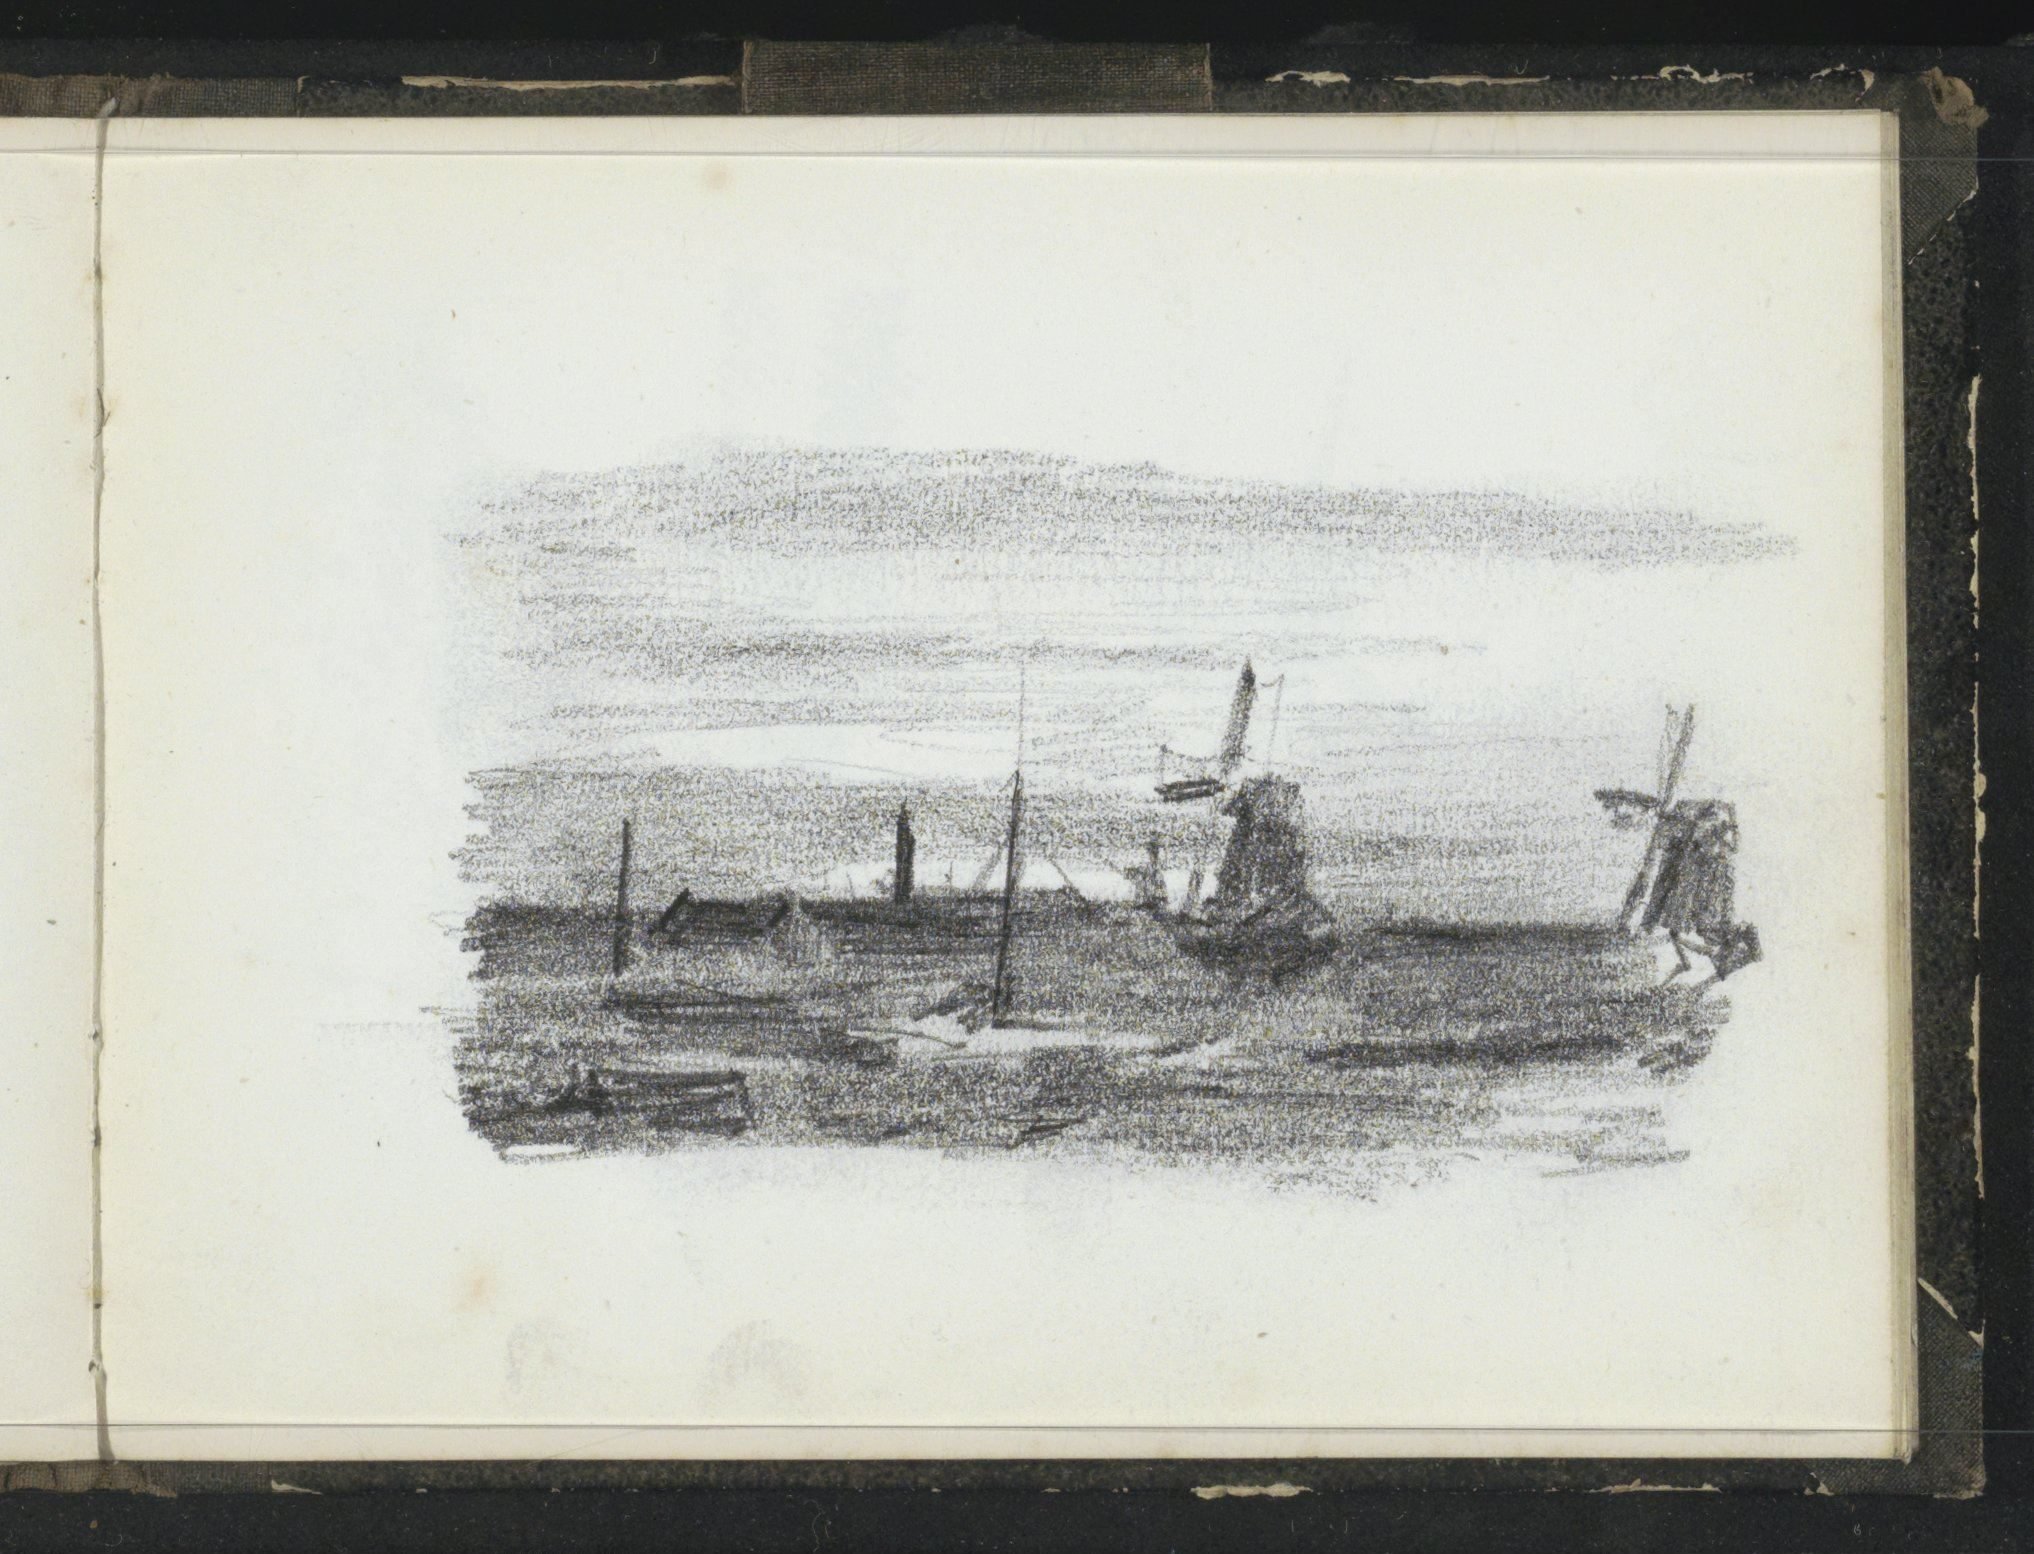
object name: sketchbook leaf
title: Landschap met molens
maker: theo hanrath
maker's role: draughtsman, painter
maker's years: 1853-1883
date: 1879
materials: paper, pencil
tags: windmill in landscape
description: Blad 21 recto uit een schetsboek met 27 bladen.